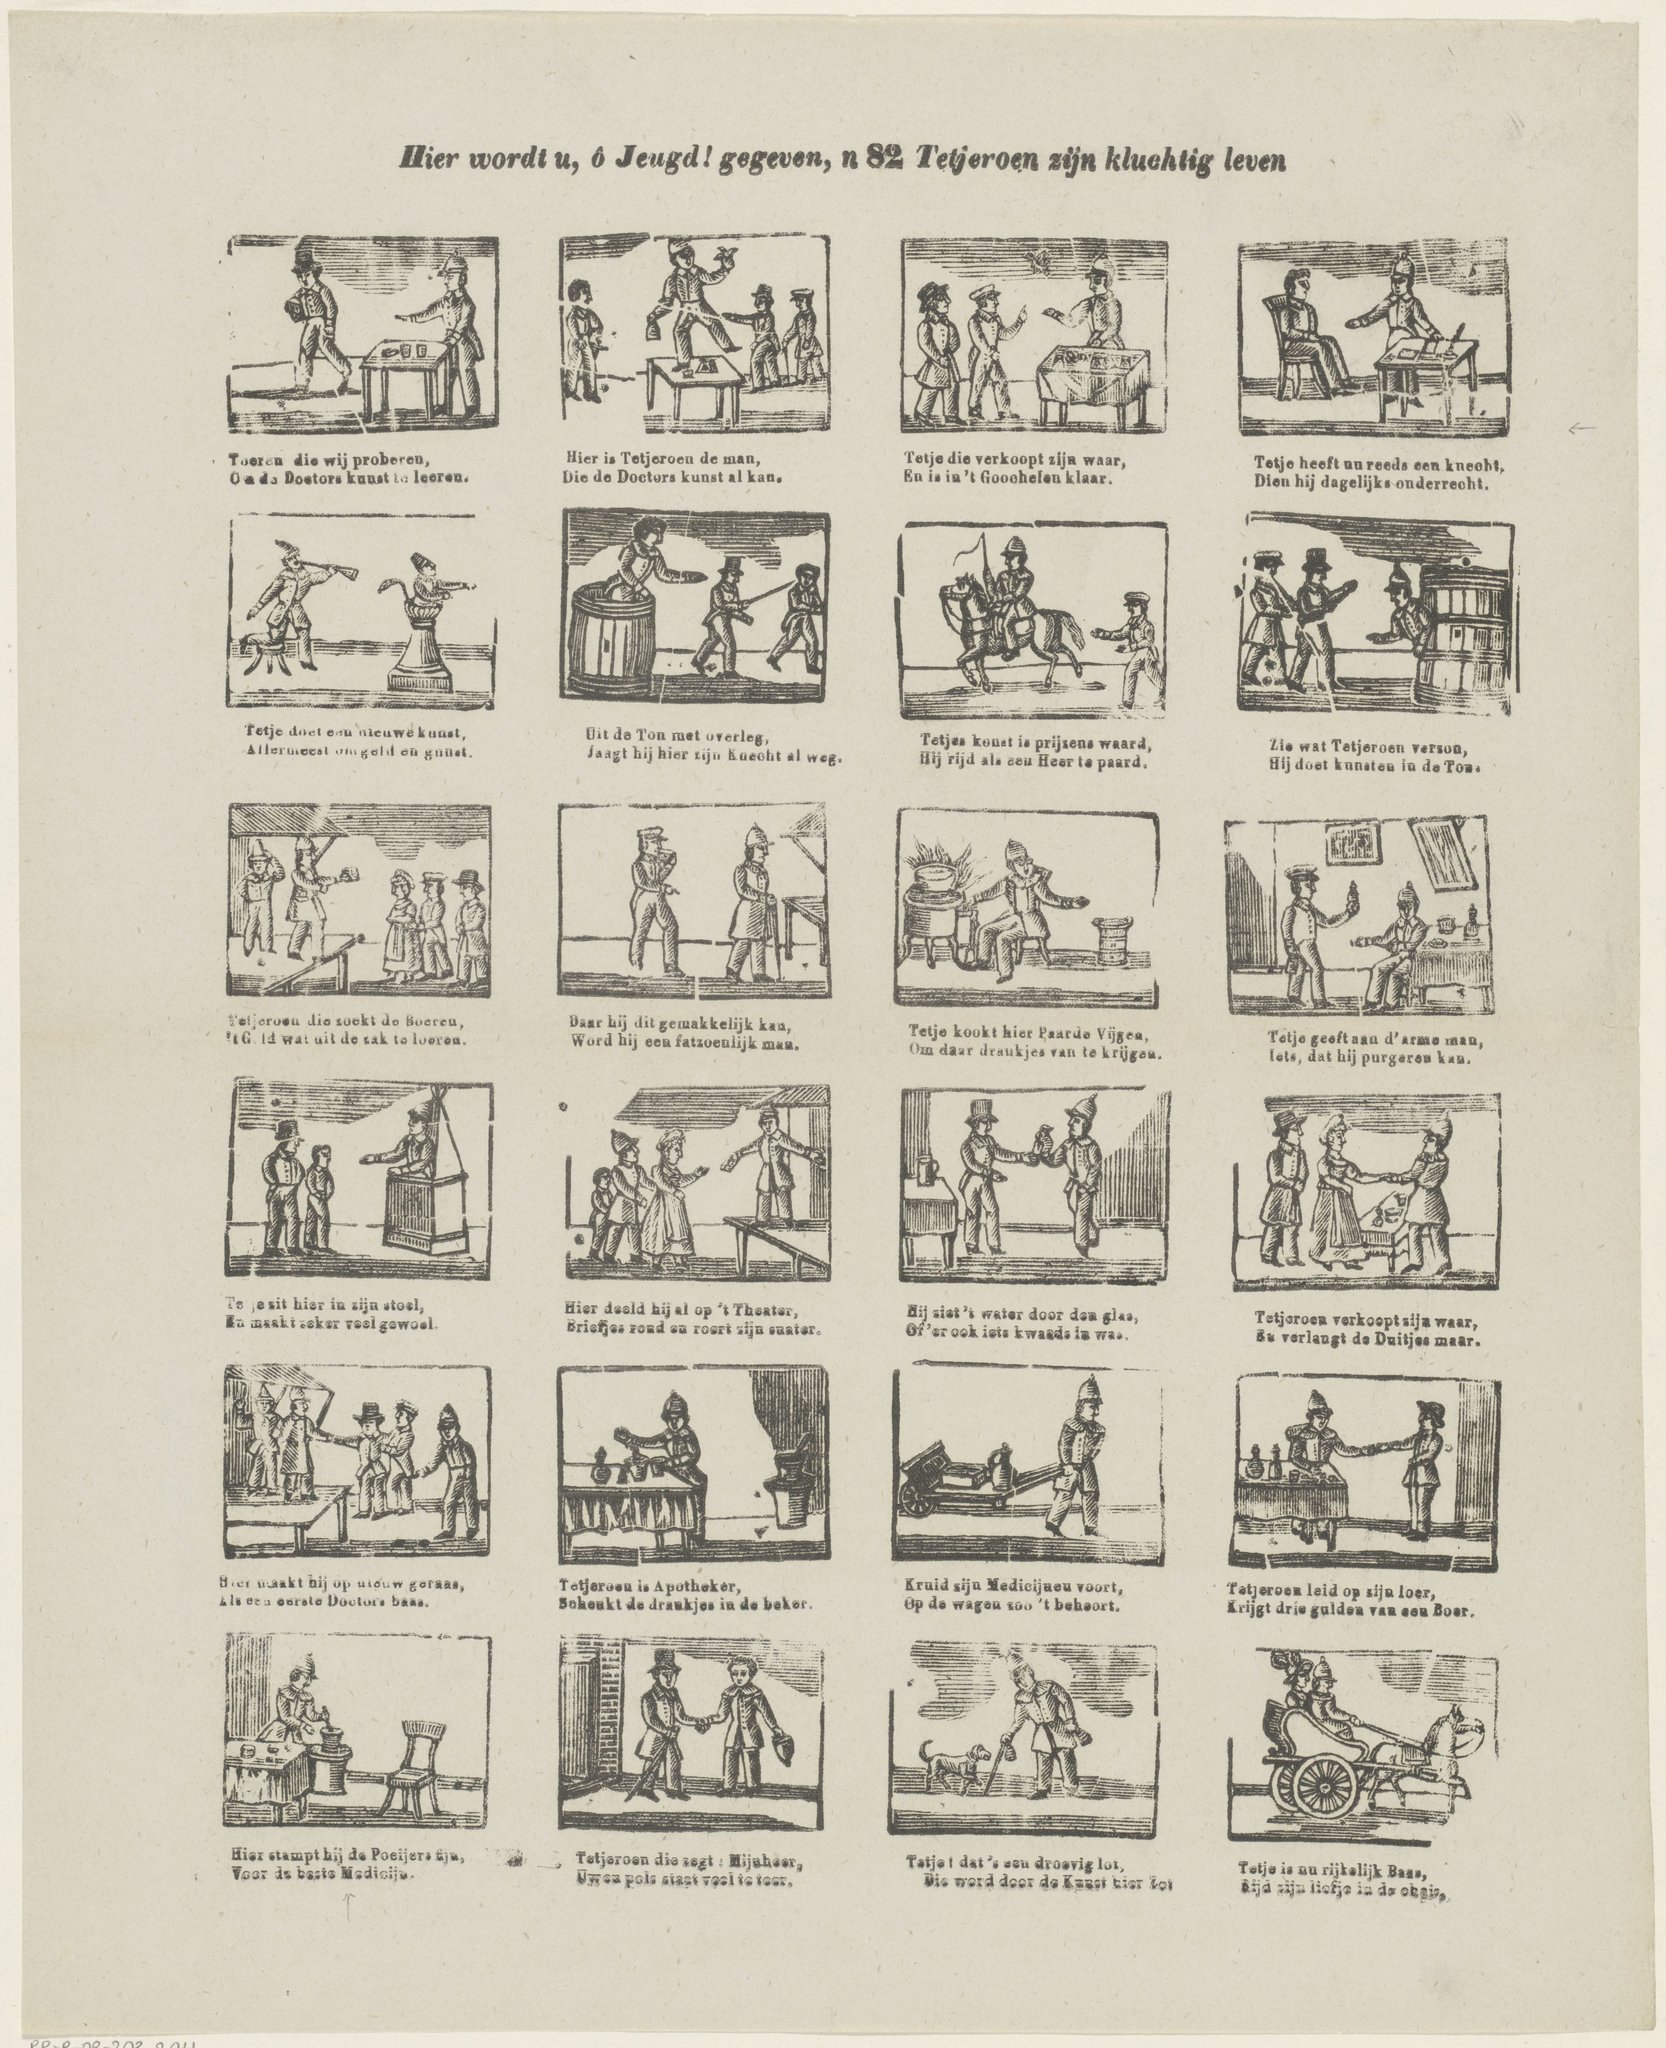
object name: print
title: Hier wordt u, ô jeugd! gegeven, / Tetjeroen zyn kluchtig leven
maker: Anonymous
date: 1856-1900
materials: paper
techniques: letterpress printing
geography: turnhout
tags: quack, charlatan, mountebank, 'saltimbanco', tales and fairy tales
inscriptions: collector's mark: Lugt 2760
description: Blad met 24 voorstellingen over het leven van de kwakzalver en grappenmaker Tetjeroen. Onder elke afbeelding een tweeregelig vers. Genummerd midden boven: n. 82.